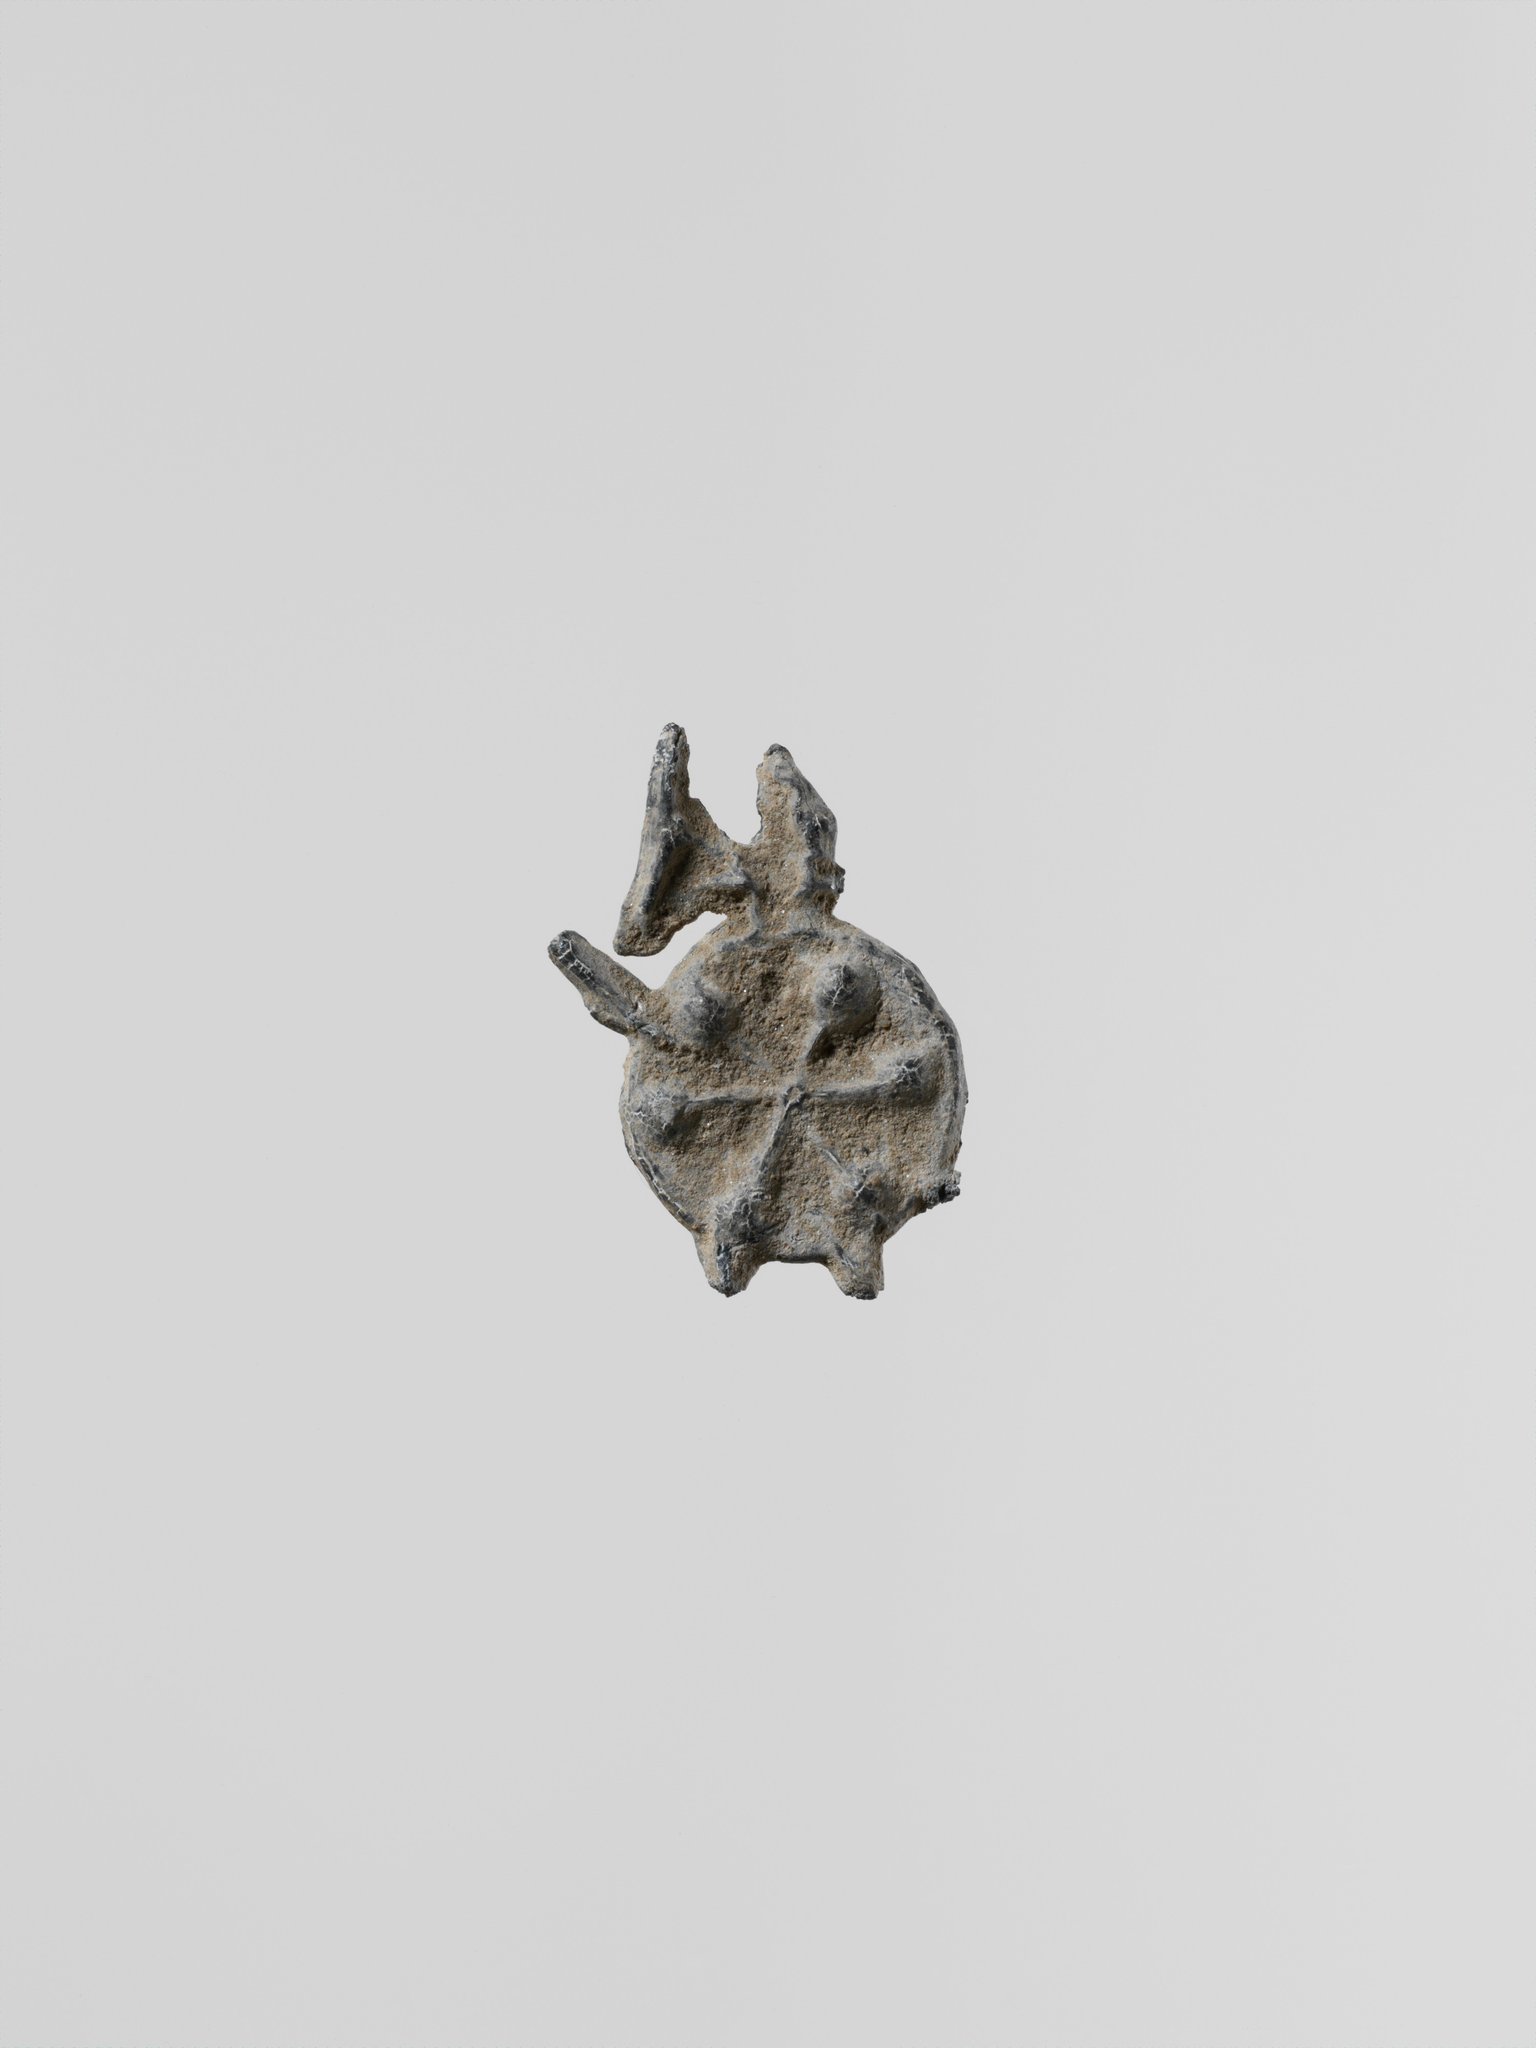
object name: statuette of a warrior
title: Statuette of a warrior-11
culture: greek, laconian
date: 7000-30 BCE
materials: lead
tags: shields